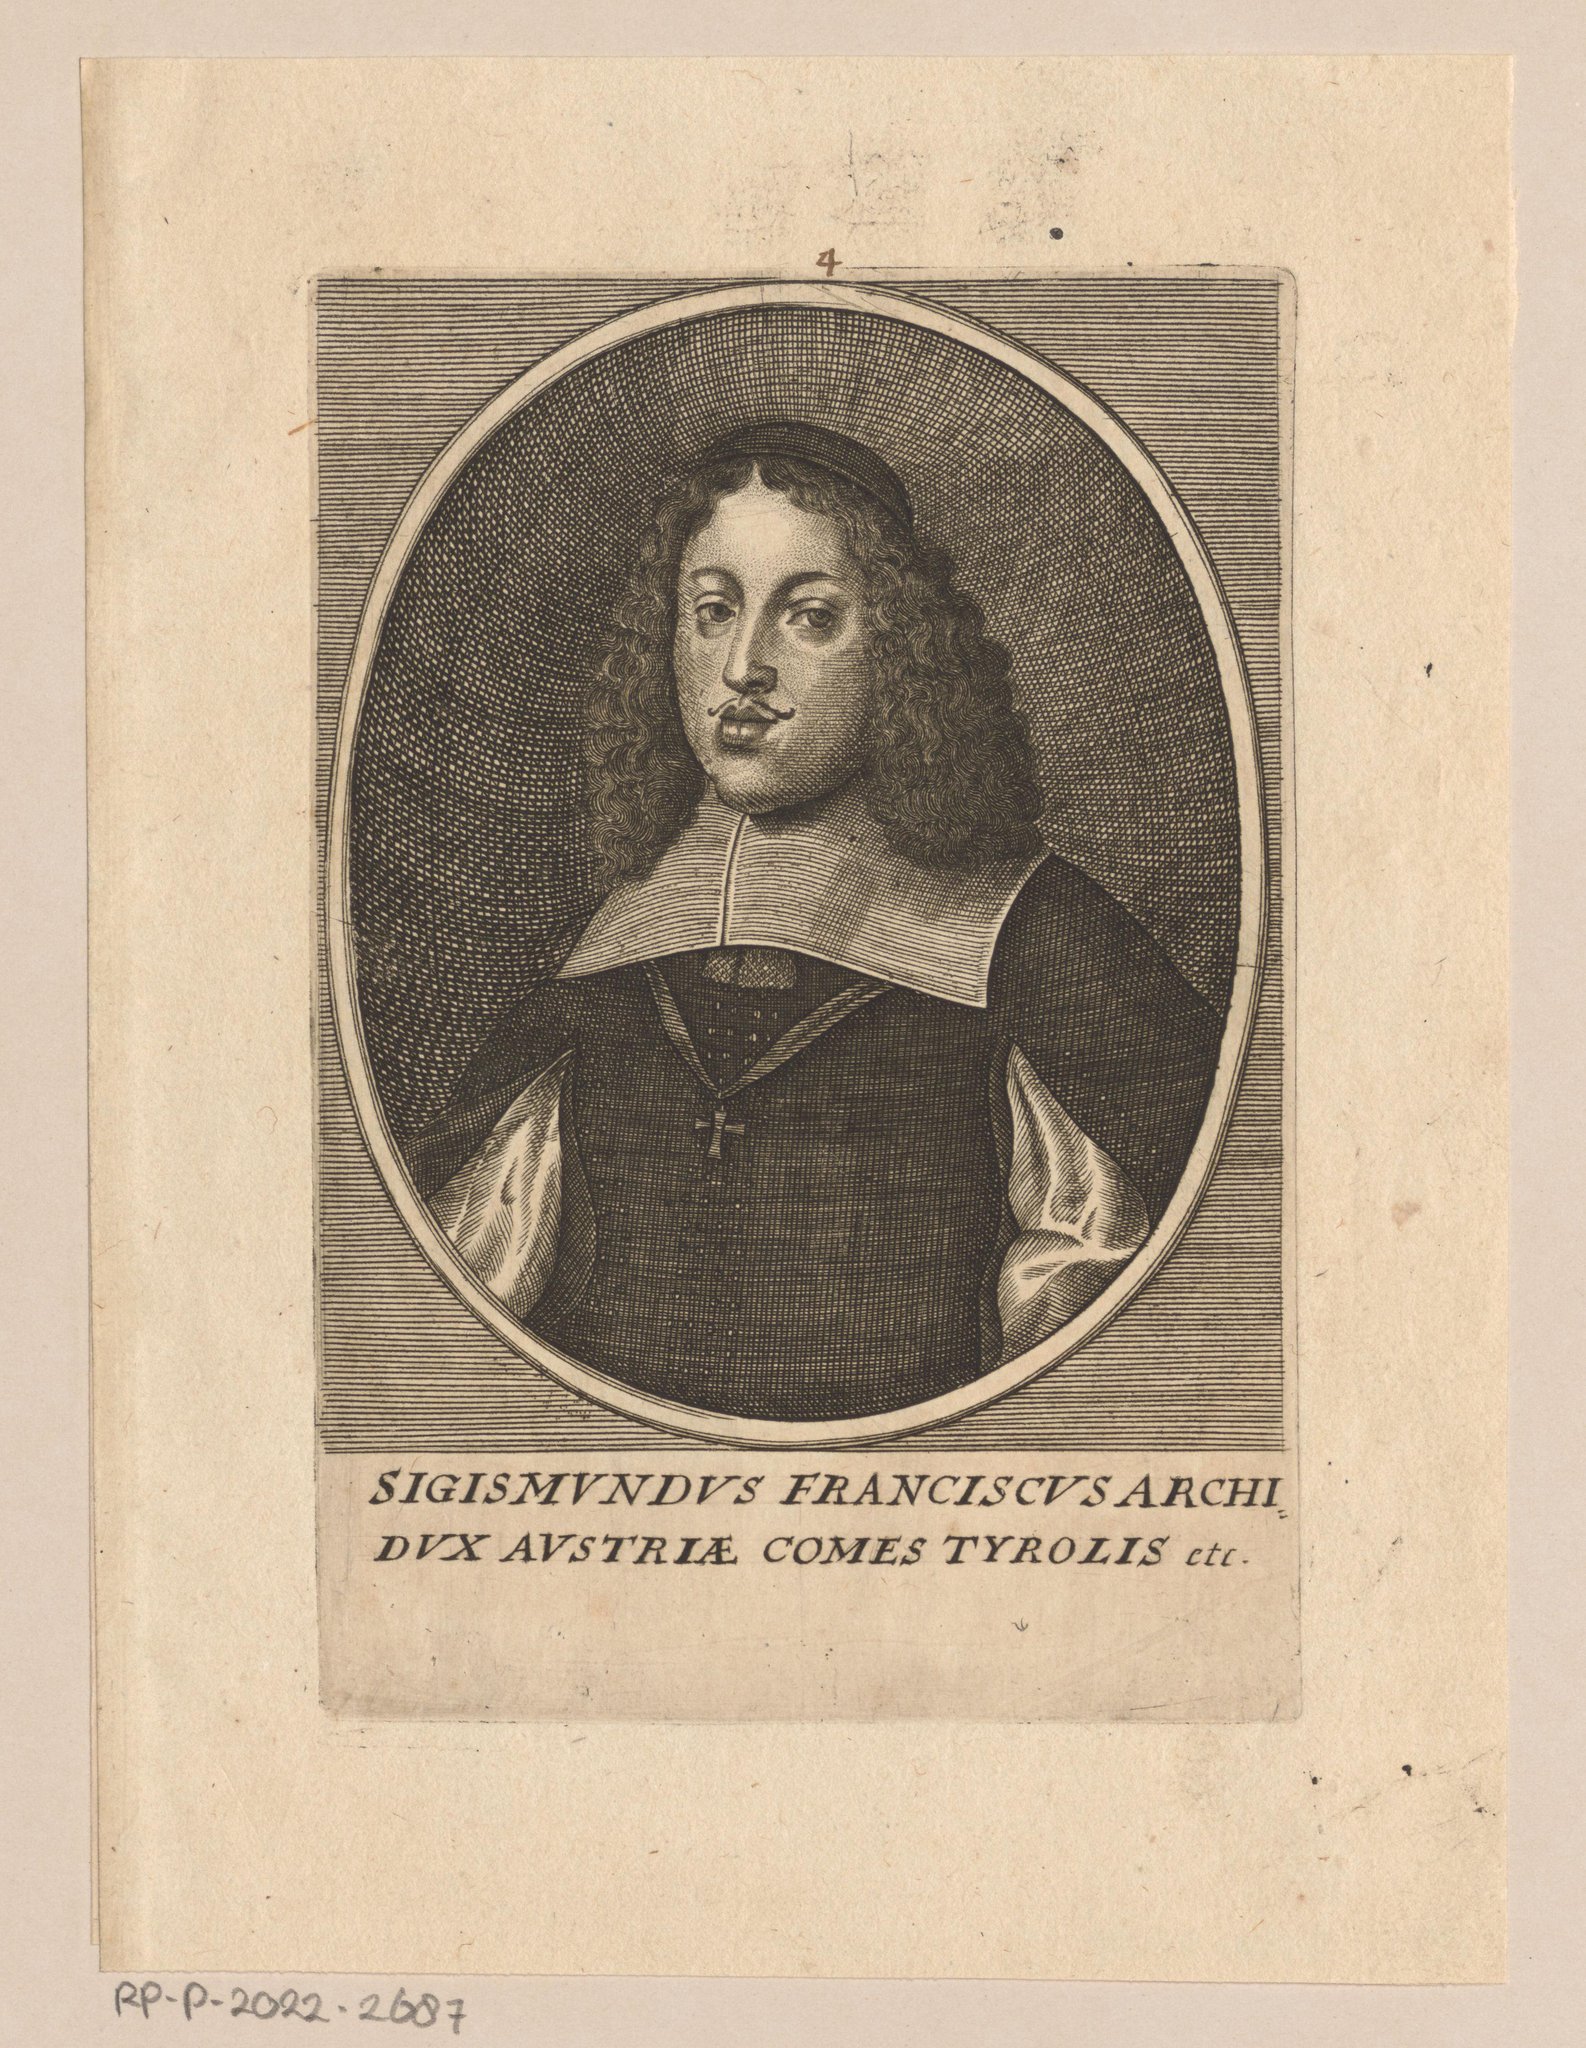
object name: print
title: Portret van Sigismund Franz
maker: Anonymous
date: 1662-1750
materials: paper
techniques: engraving, intaglio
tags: historical persons, other sovereign (with title)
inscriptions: number: ‘4’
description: Met tweeregelig onderschrift in het Latijn.